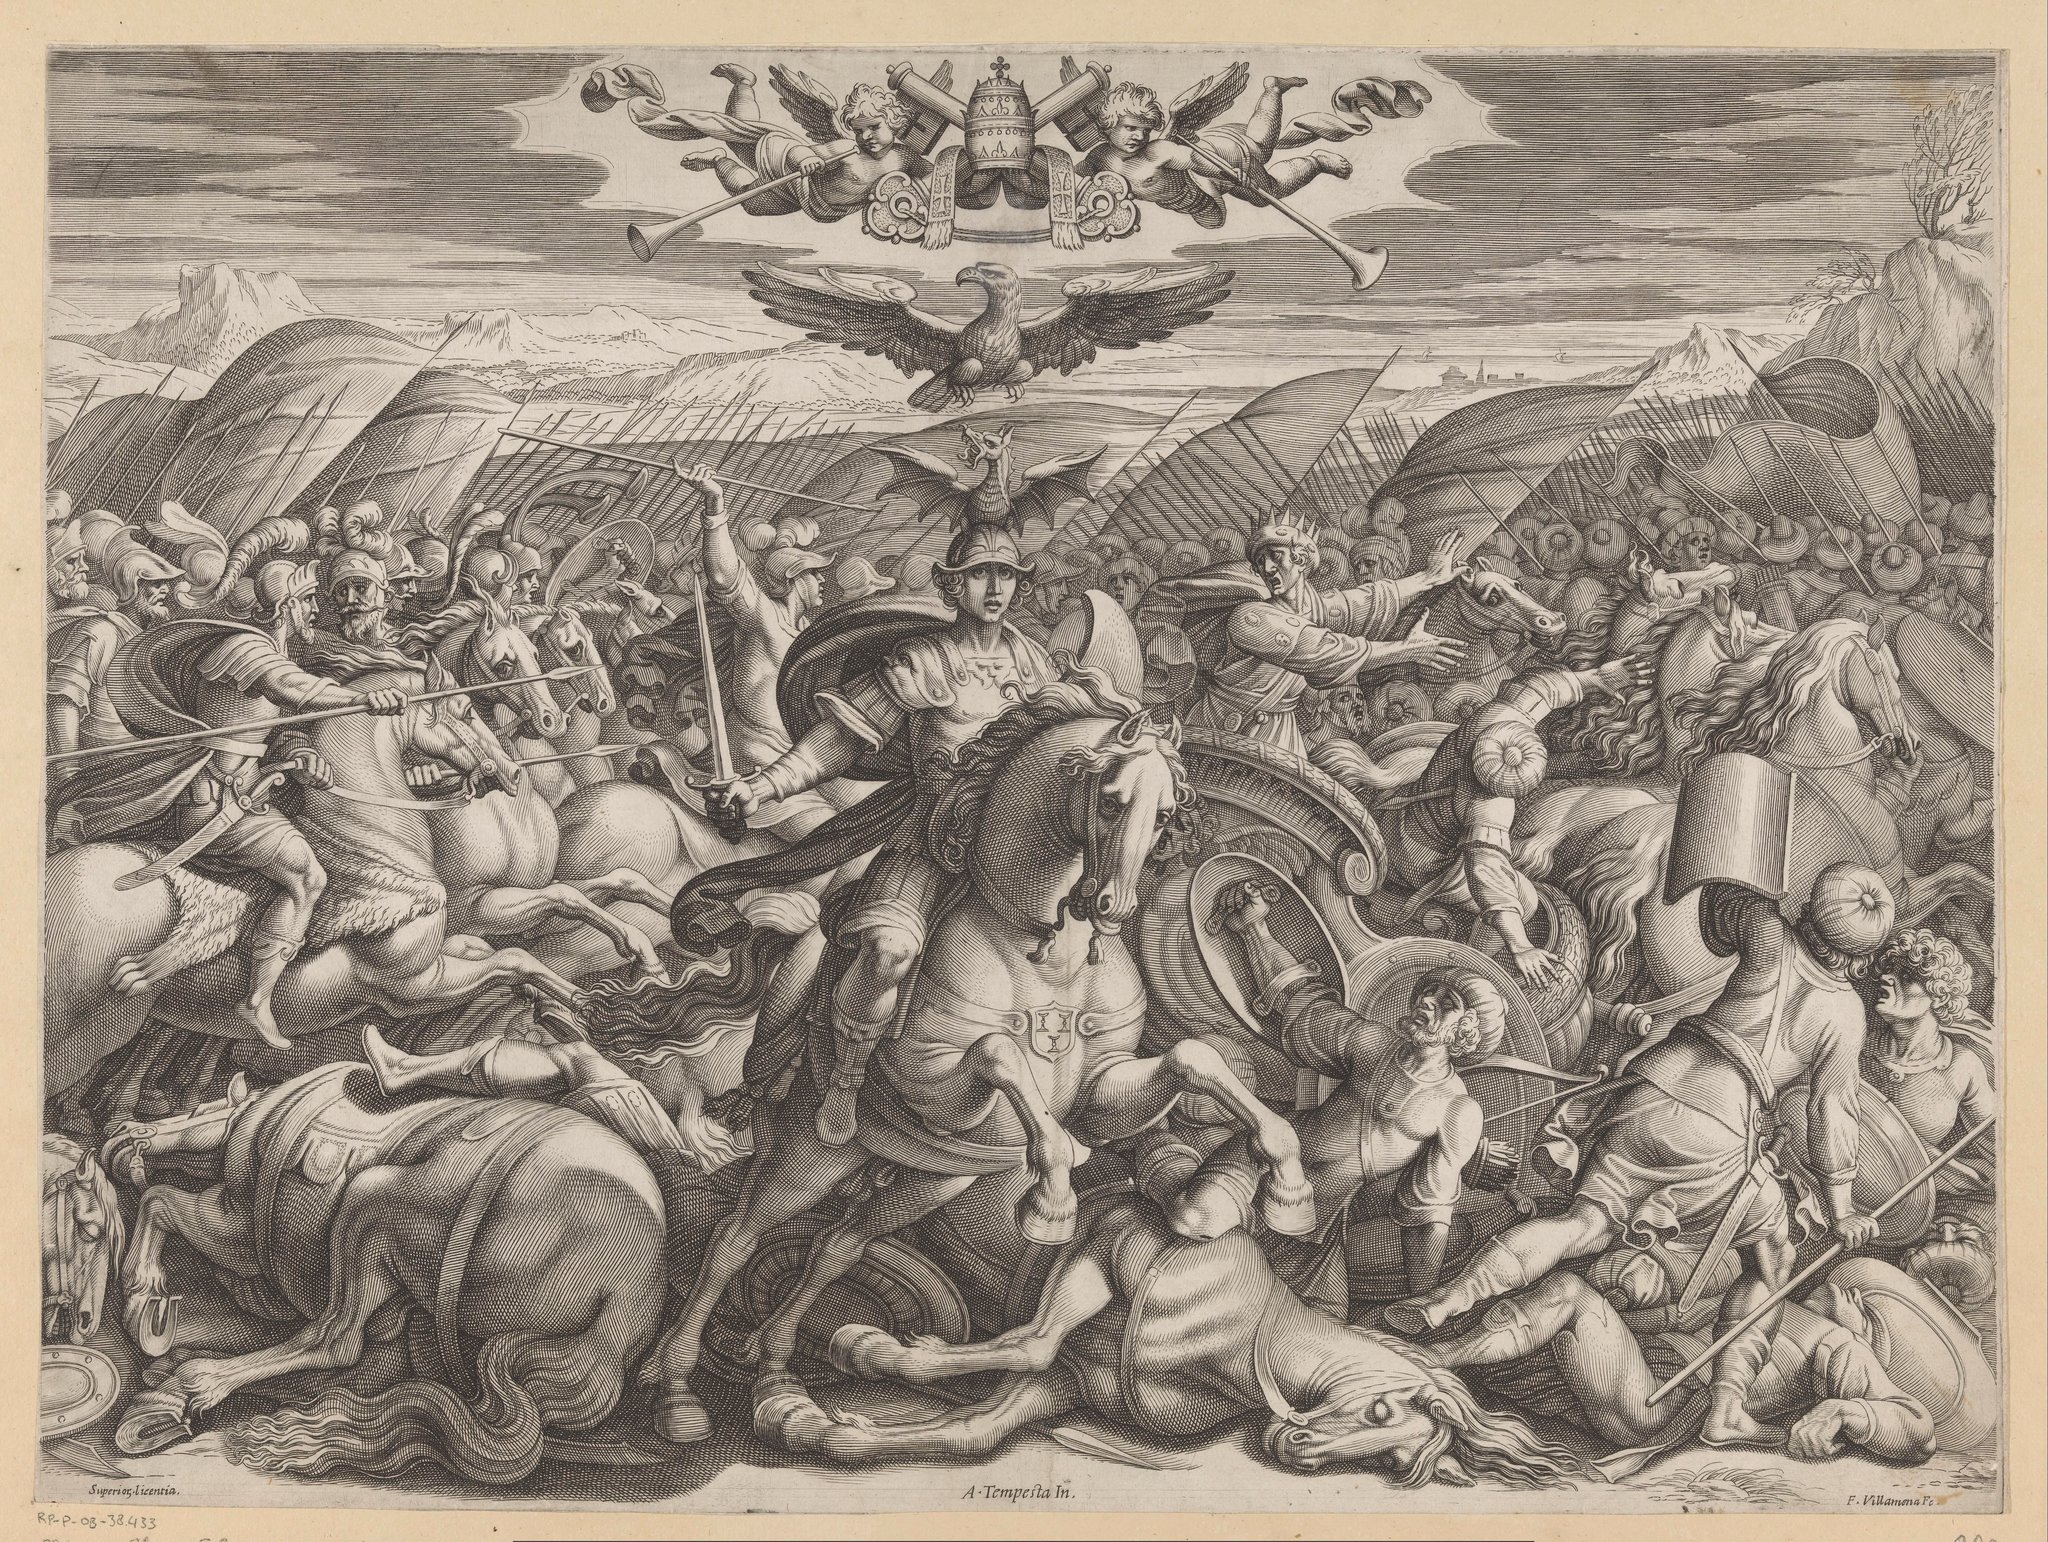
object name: print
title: Slag bij Gaugamela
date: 1576-1624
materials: paper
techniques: engraving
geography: italy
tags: persia, battle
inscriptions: collector's mark: Lugt 240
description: Slag bij Gaugamela met links de Macedoniërs onder leiding van Alexander de Grote en rechts de Perzen onder leiding van koning Darius III.